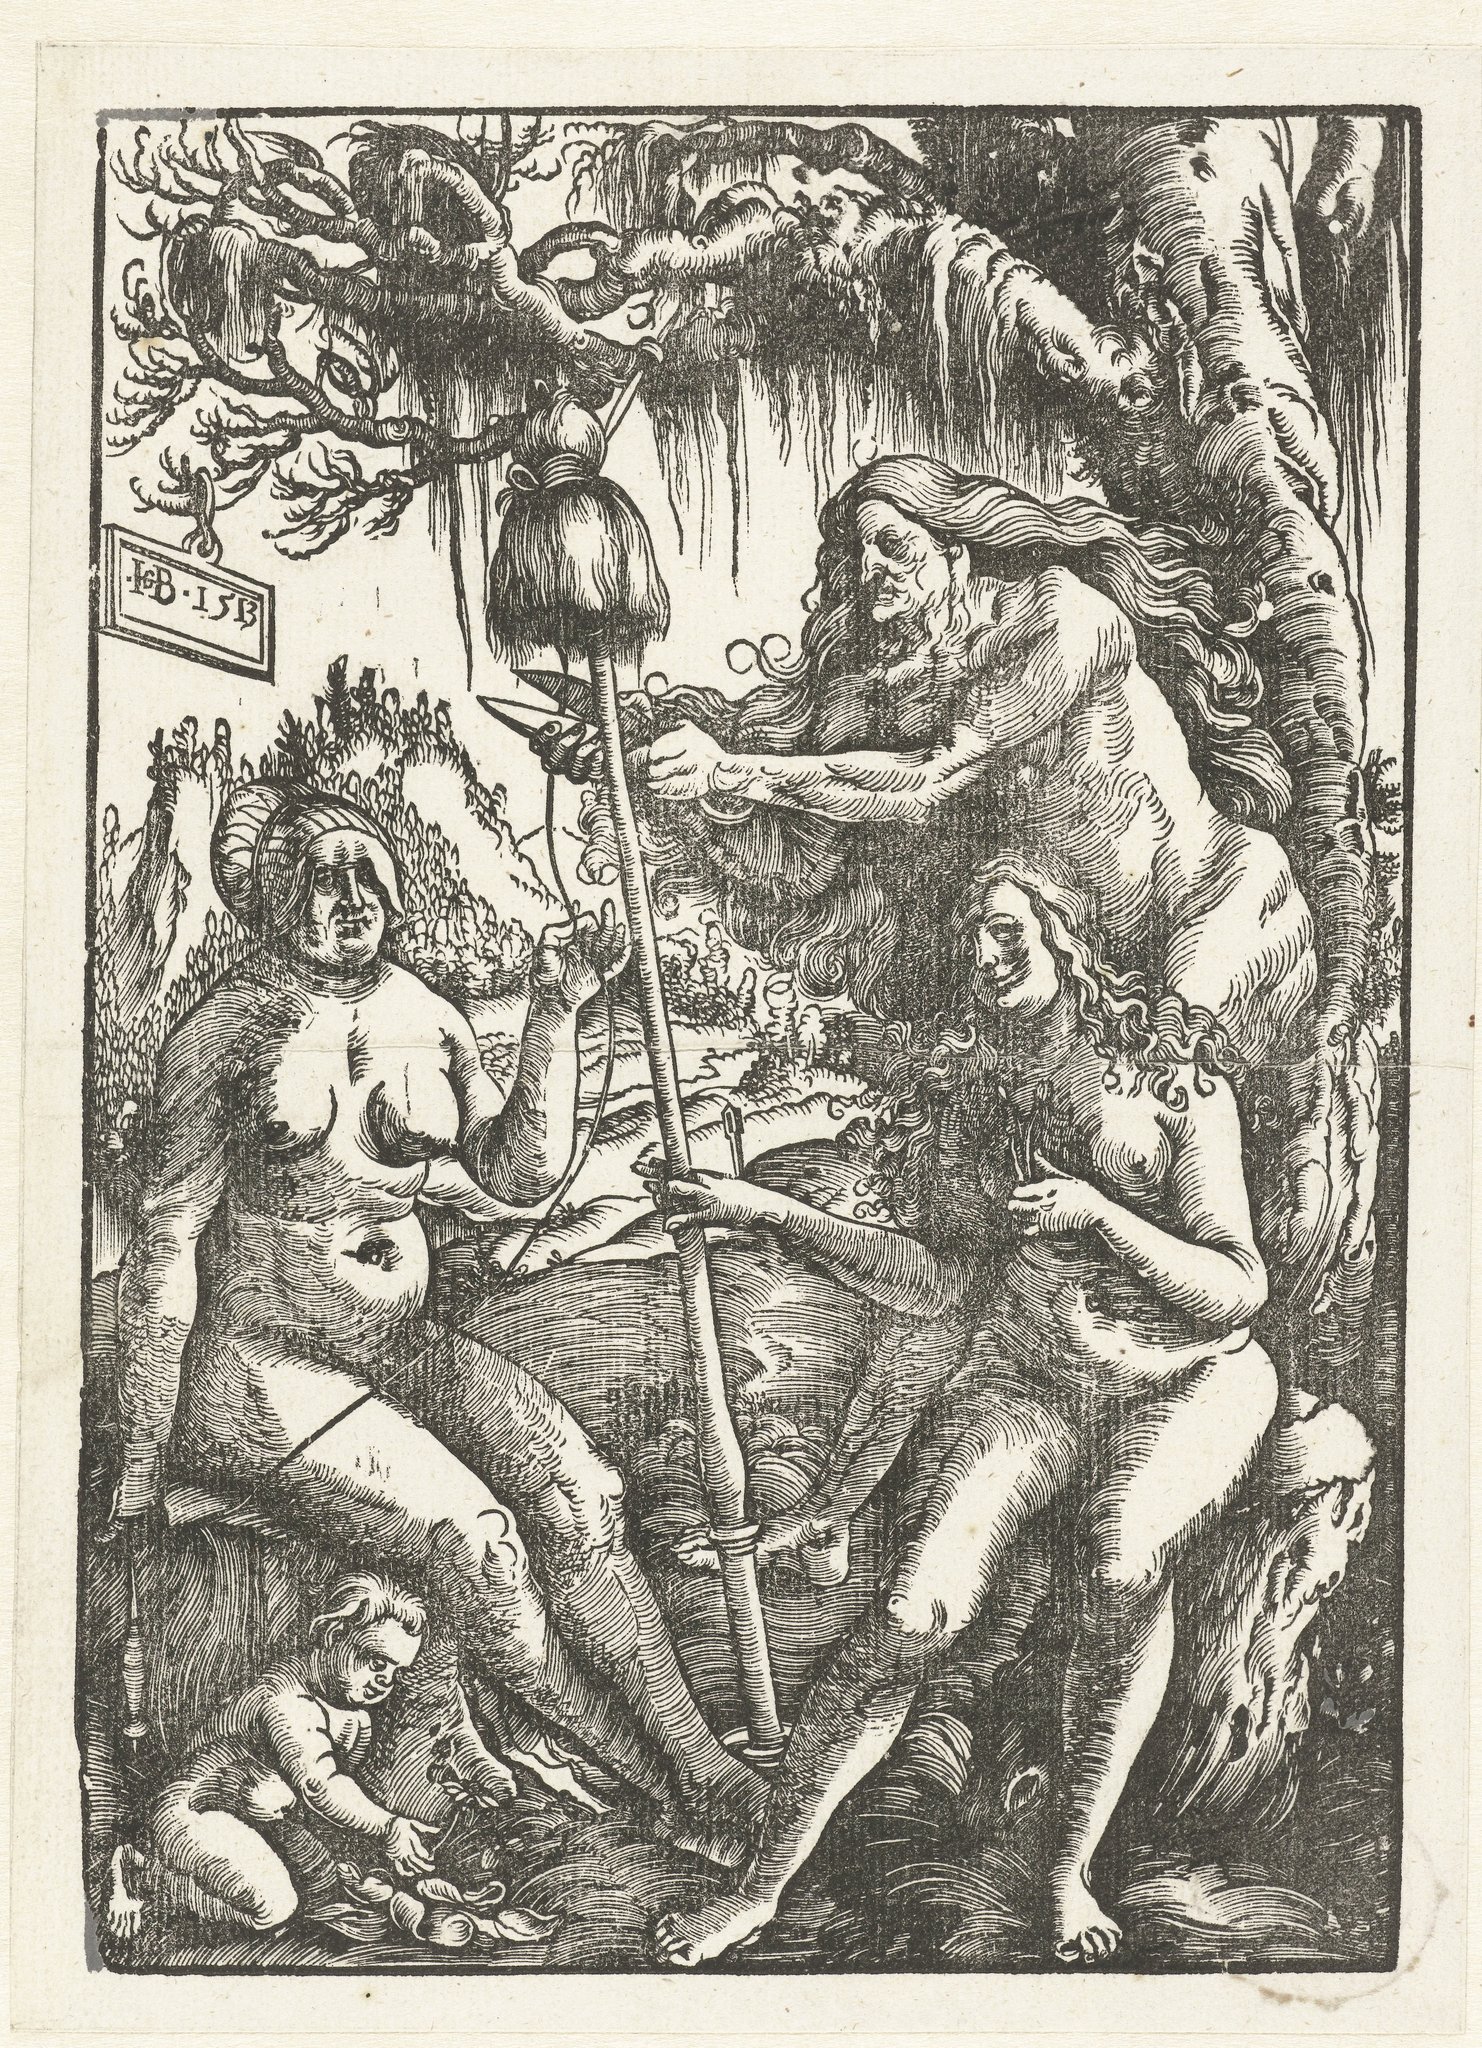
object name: print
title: Drie schikgodinnen: Lachesis, Atropos en Clotho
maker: hans baldung grien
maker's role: draughtsman, print maker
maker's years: 1484-1545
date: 1513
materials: paper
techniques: woodcut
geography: freiburg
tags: fates, parcae (moirae)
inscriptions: collector's mark: Lugt 240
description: De drie schikgodinnen Lachesis, Atropos en Clotho spinnen de levensdraad op een spinrokken en bepalen de levensloop en de lengte van de draad door deze te meten en door te knippen. De drie vrouwen zitten naakt in een landschap bij een boom. Ze verbeelden de drie levensfasen. Links op de voorgrond plukt een klein kind een bloem.